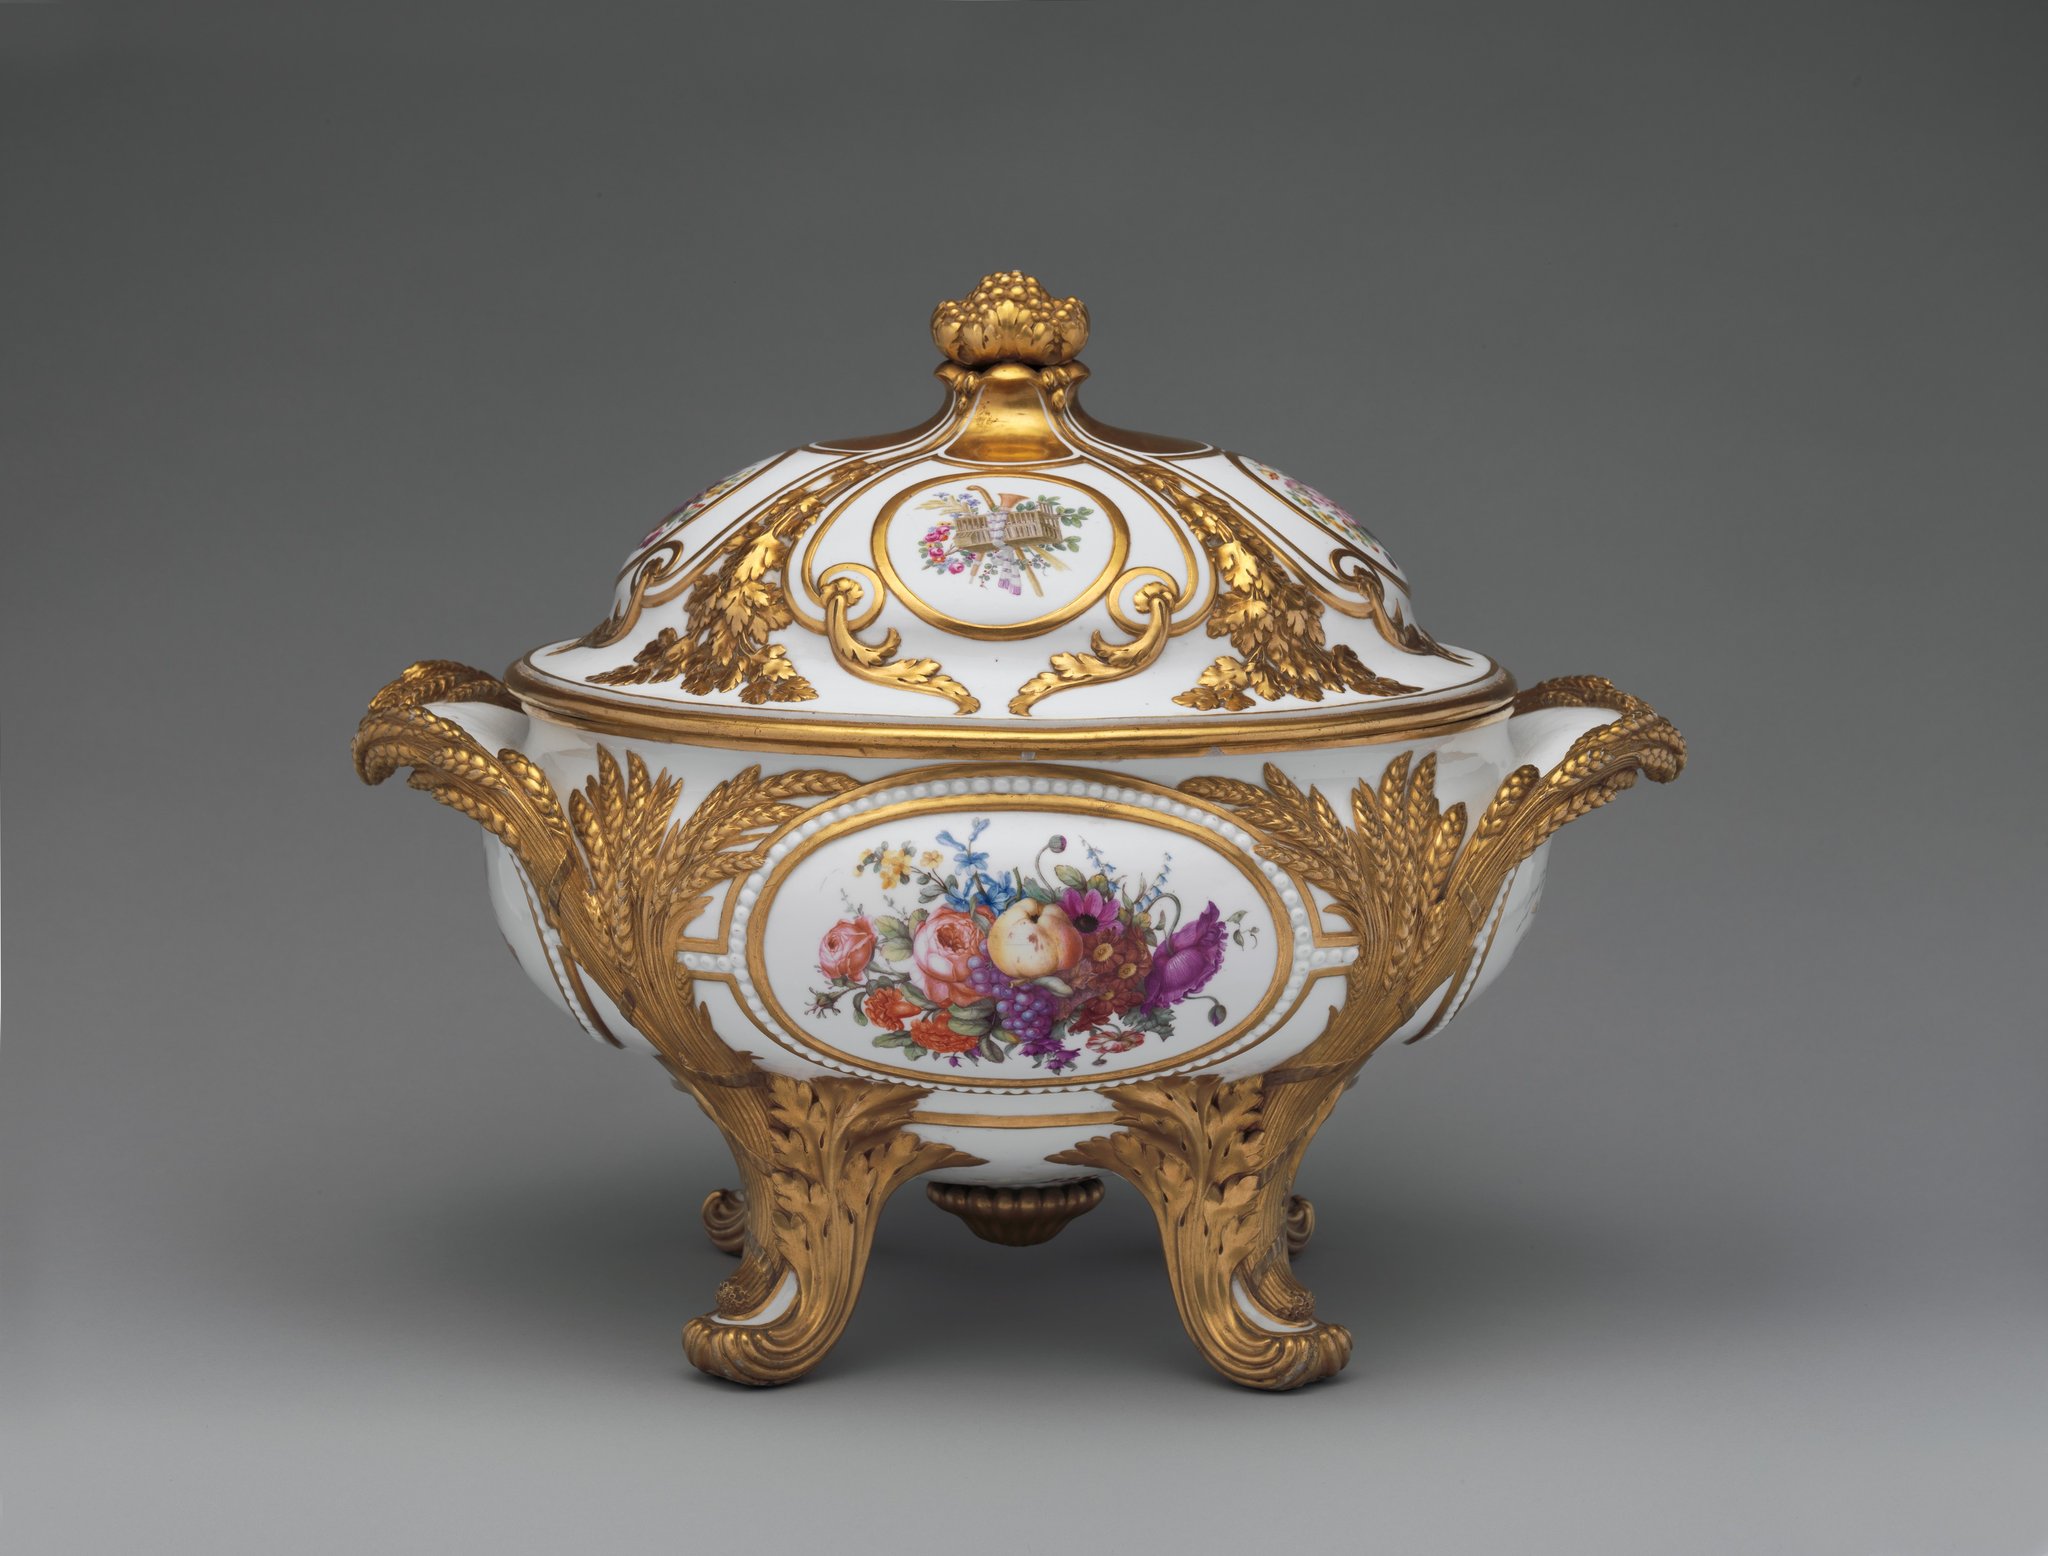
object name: tureen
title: Tureen with cover (Terrine épis de blé or épis en or et plateau)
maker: sèvres manufactory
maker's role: manufactory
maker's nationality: french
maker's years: 1740-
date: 1777-1785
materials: enamel, gold, hard paste porcelain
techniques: polychrome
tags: fruit,flowers